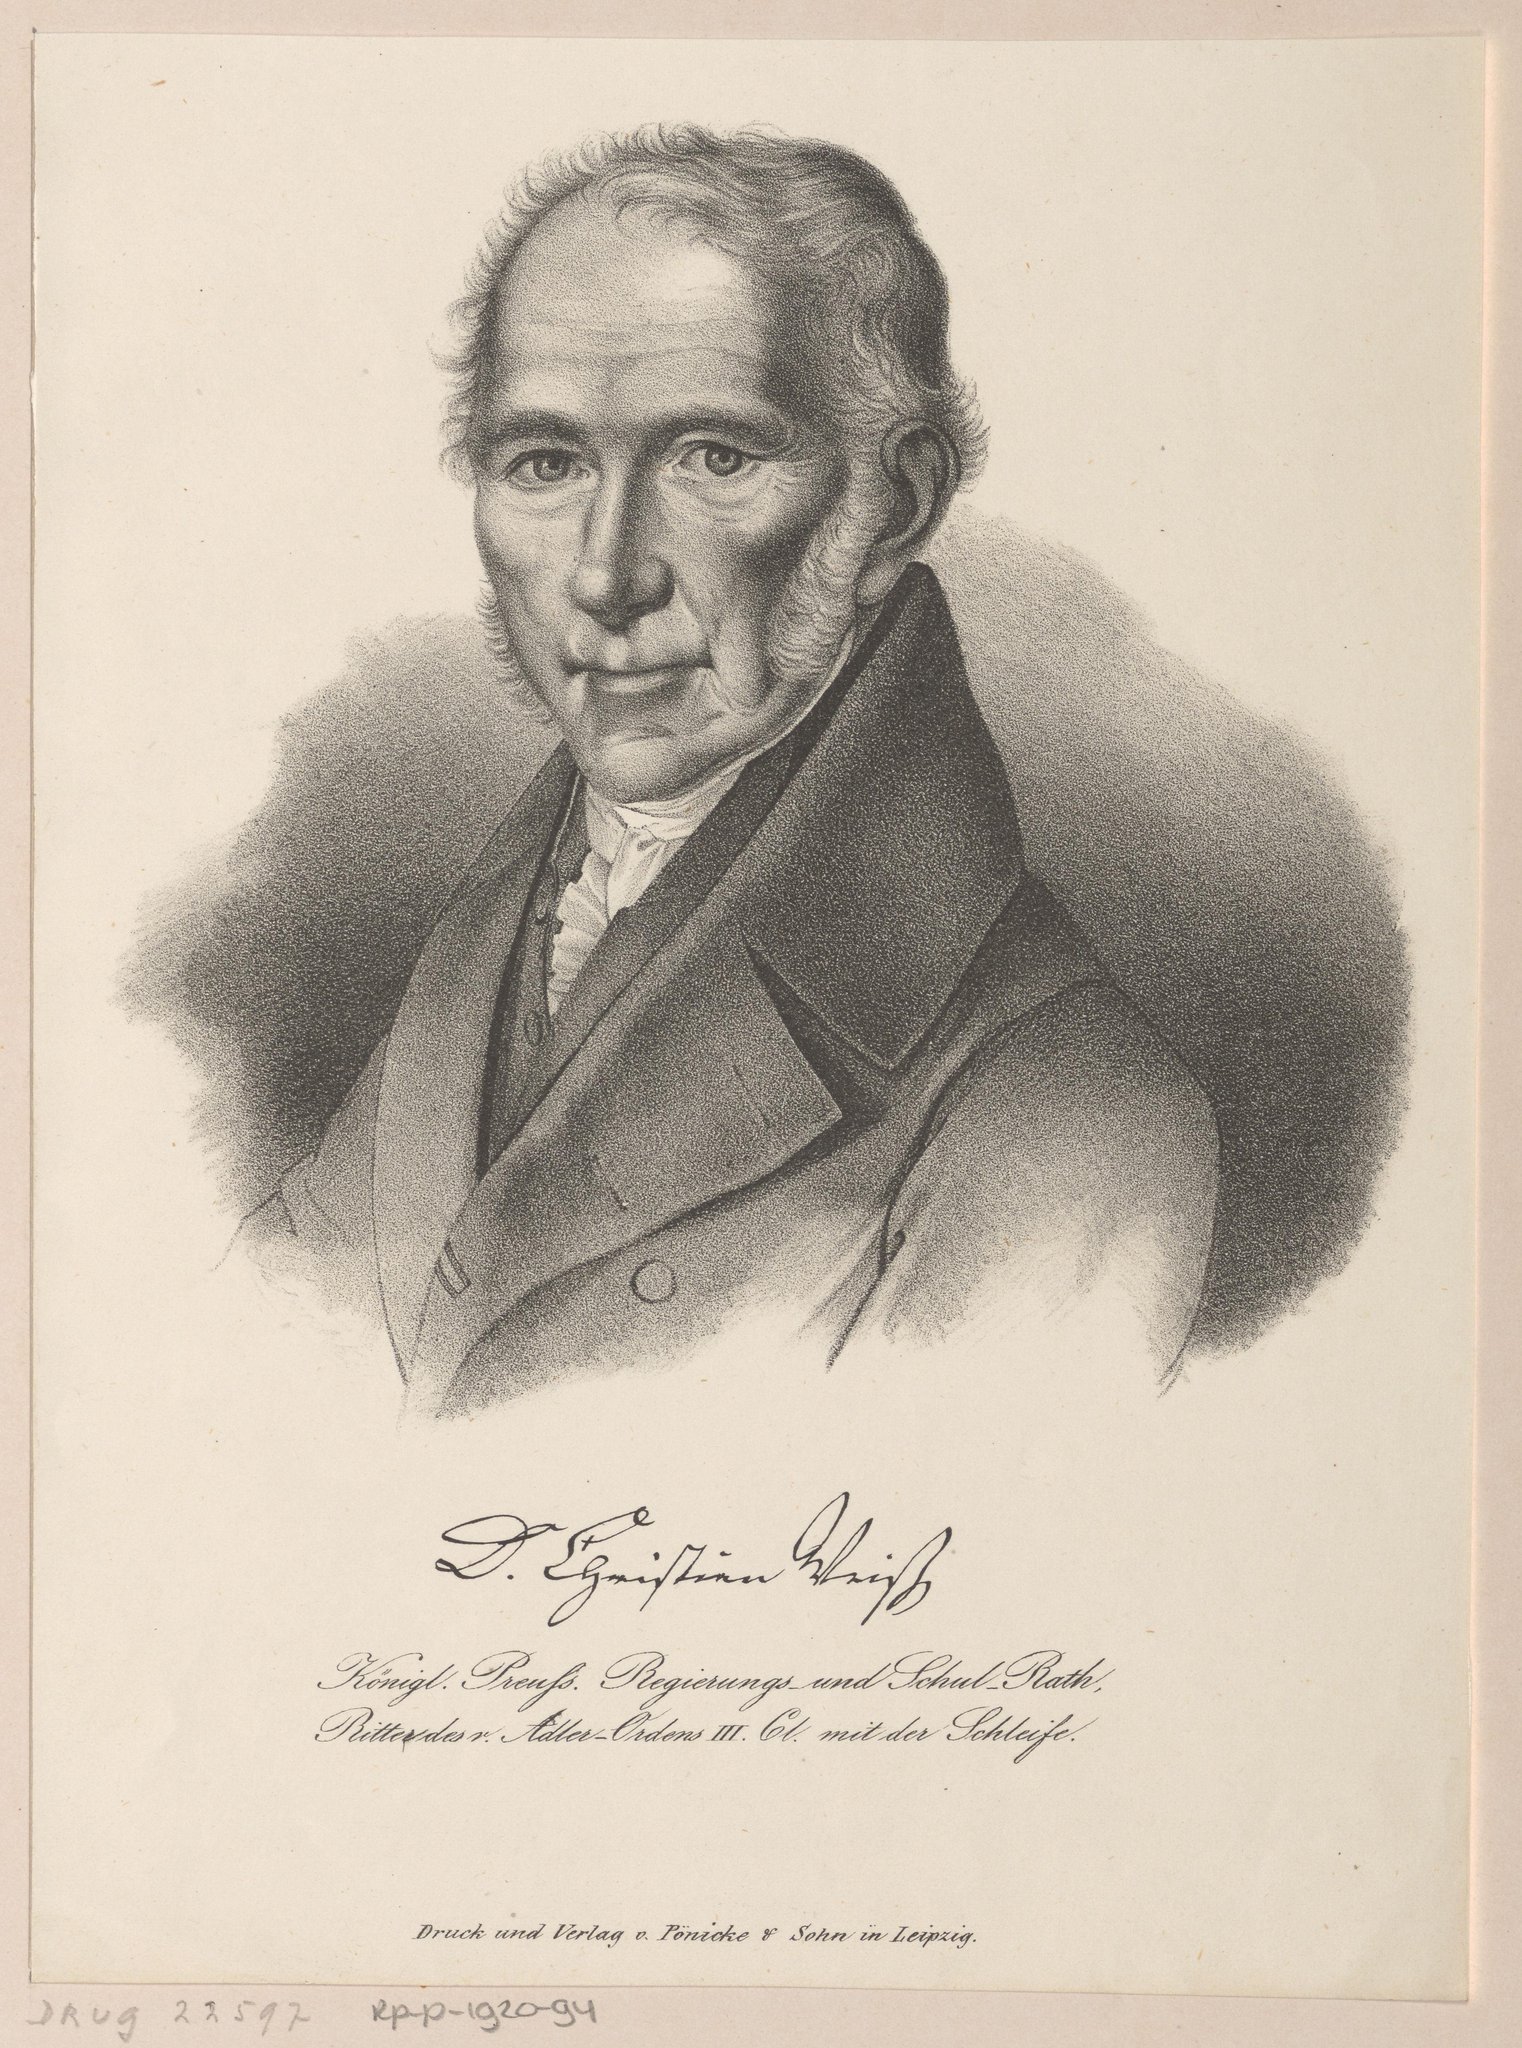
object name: print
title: Portret van Christian Weiss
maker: Anonymous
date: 1830-1848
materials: paper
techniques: lithograph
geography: leipzig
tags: historical persons, physician, doctor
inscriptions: collector's mark: Lugt 2228